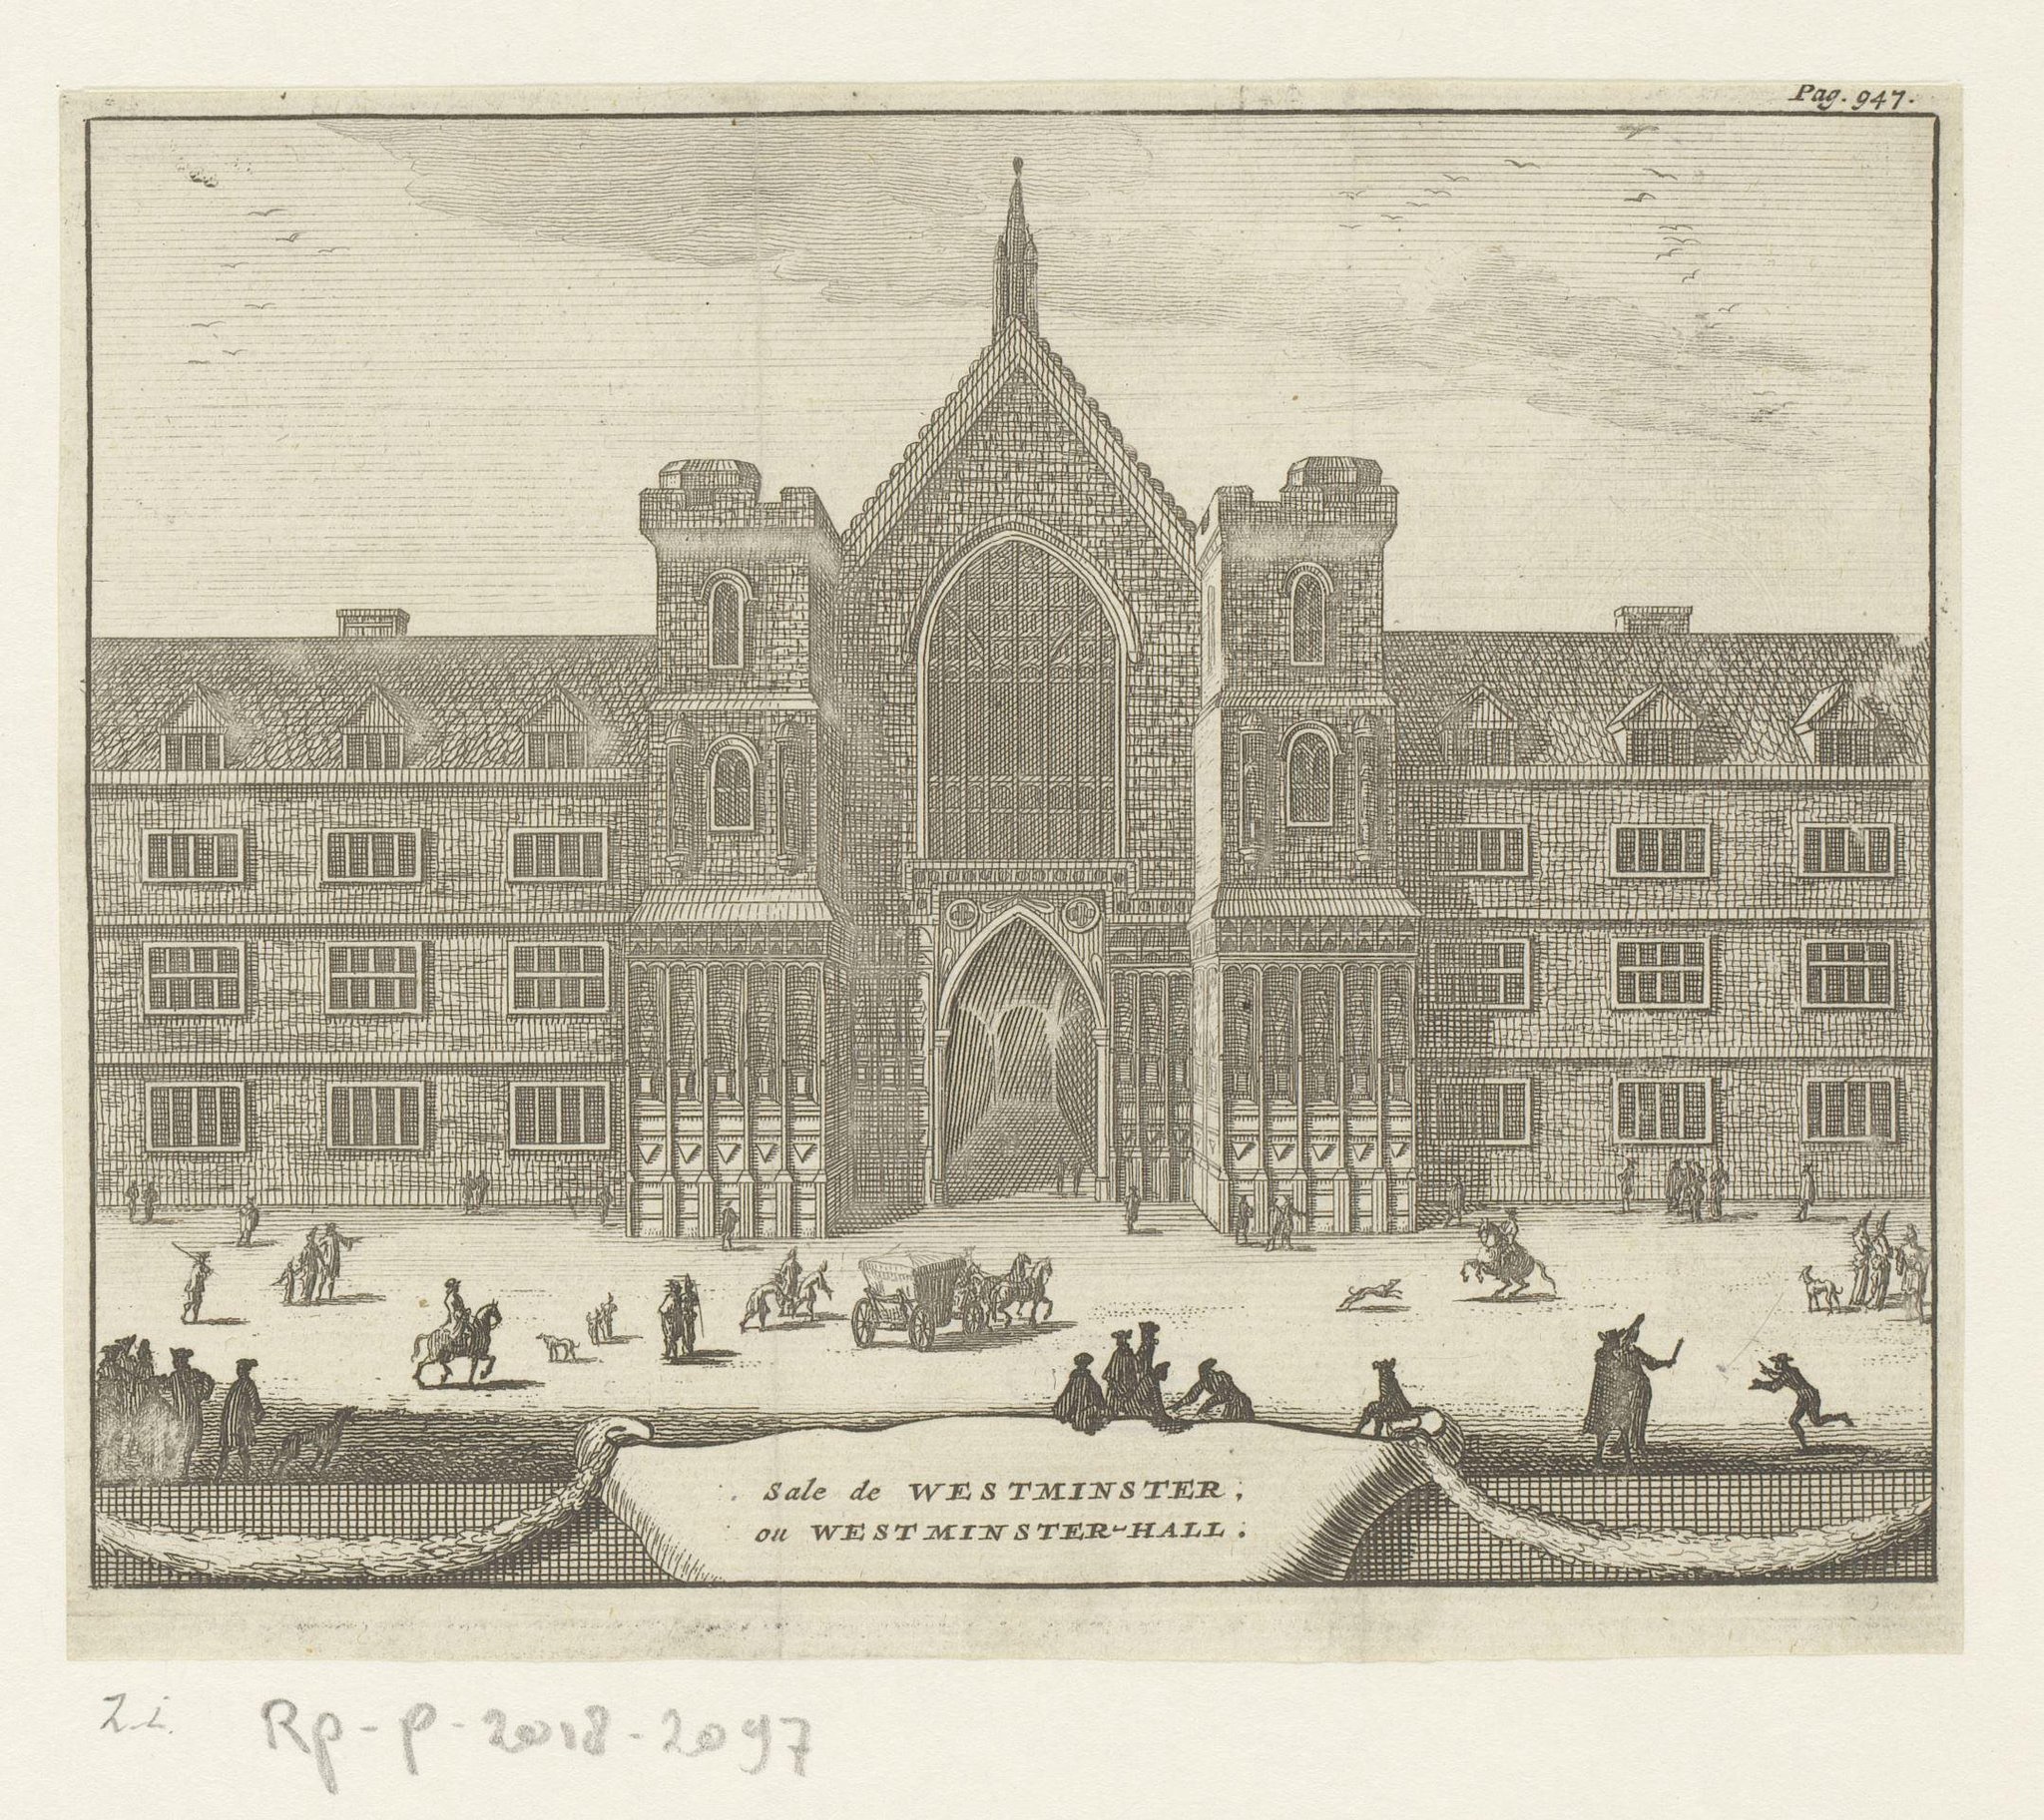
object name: print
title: Westwood in Worcestershire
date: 1707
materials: paper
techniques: etching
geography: leiden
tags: palace, lower house, parliament, chamber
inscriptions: collector's mark: Lugt 2228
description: Prent gebruikt in: Beeverell, James. Les Delices de la Grande Bretagne et de l'Irlande (...). Leiden: Pieter van der Aa, 1707.